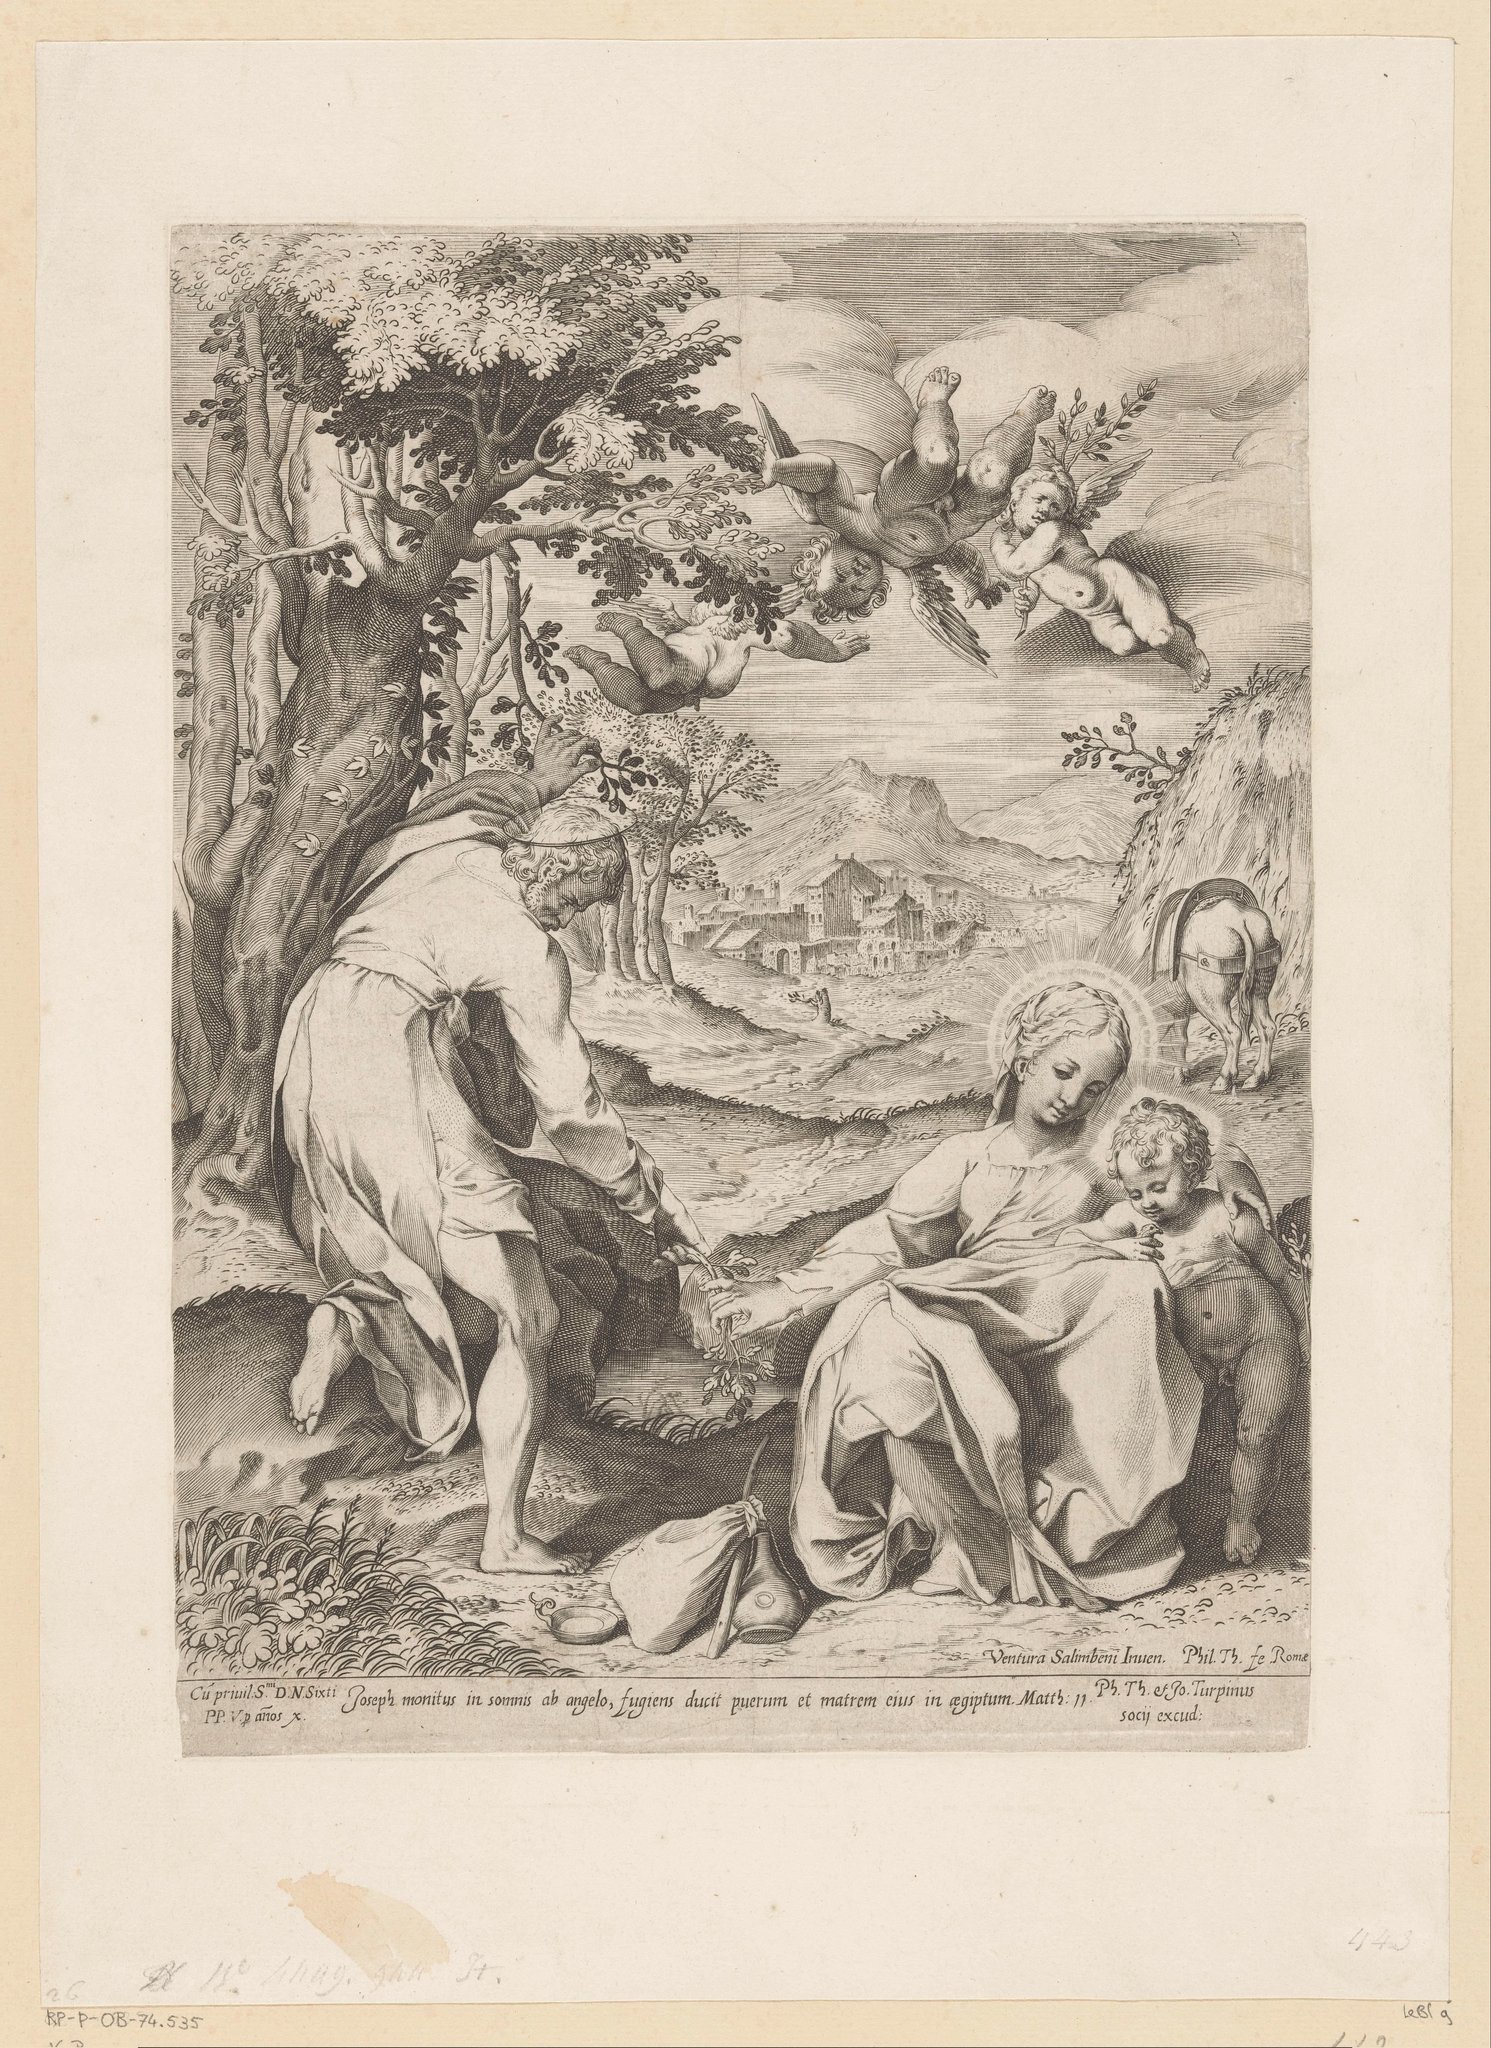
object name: print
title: Rest on the Flight into Egypt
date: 1588-1590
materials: paper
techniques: engraving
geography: vatican city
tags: rest on the flight into egypt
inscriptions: collector's mark: Lugt 240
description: De vlucht naar Egypte met links Jozef die takken van een boom breekt en aan Maria met kind aan de rechterzijde geeft.